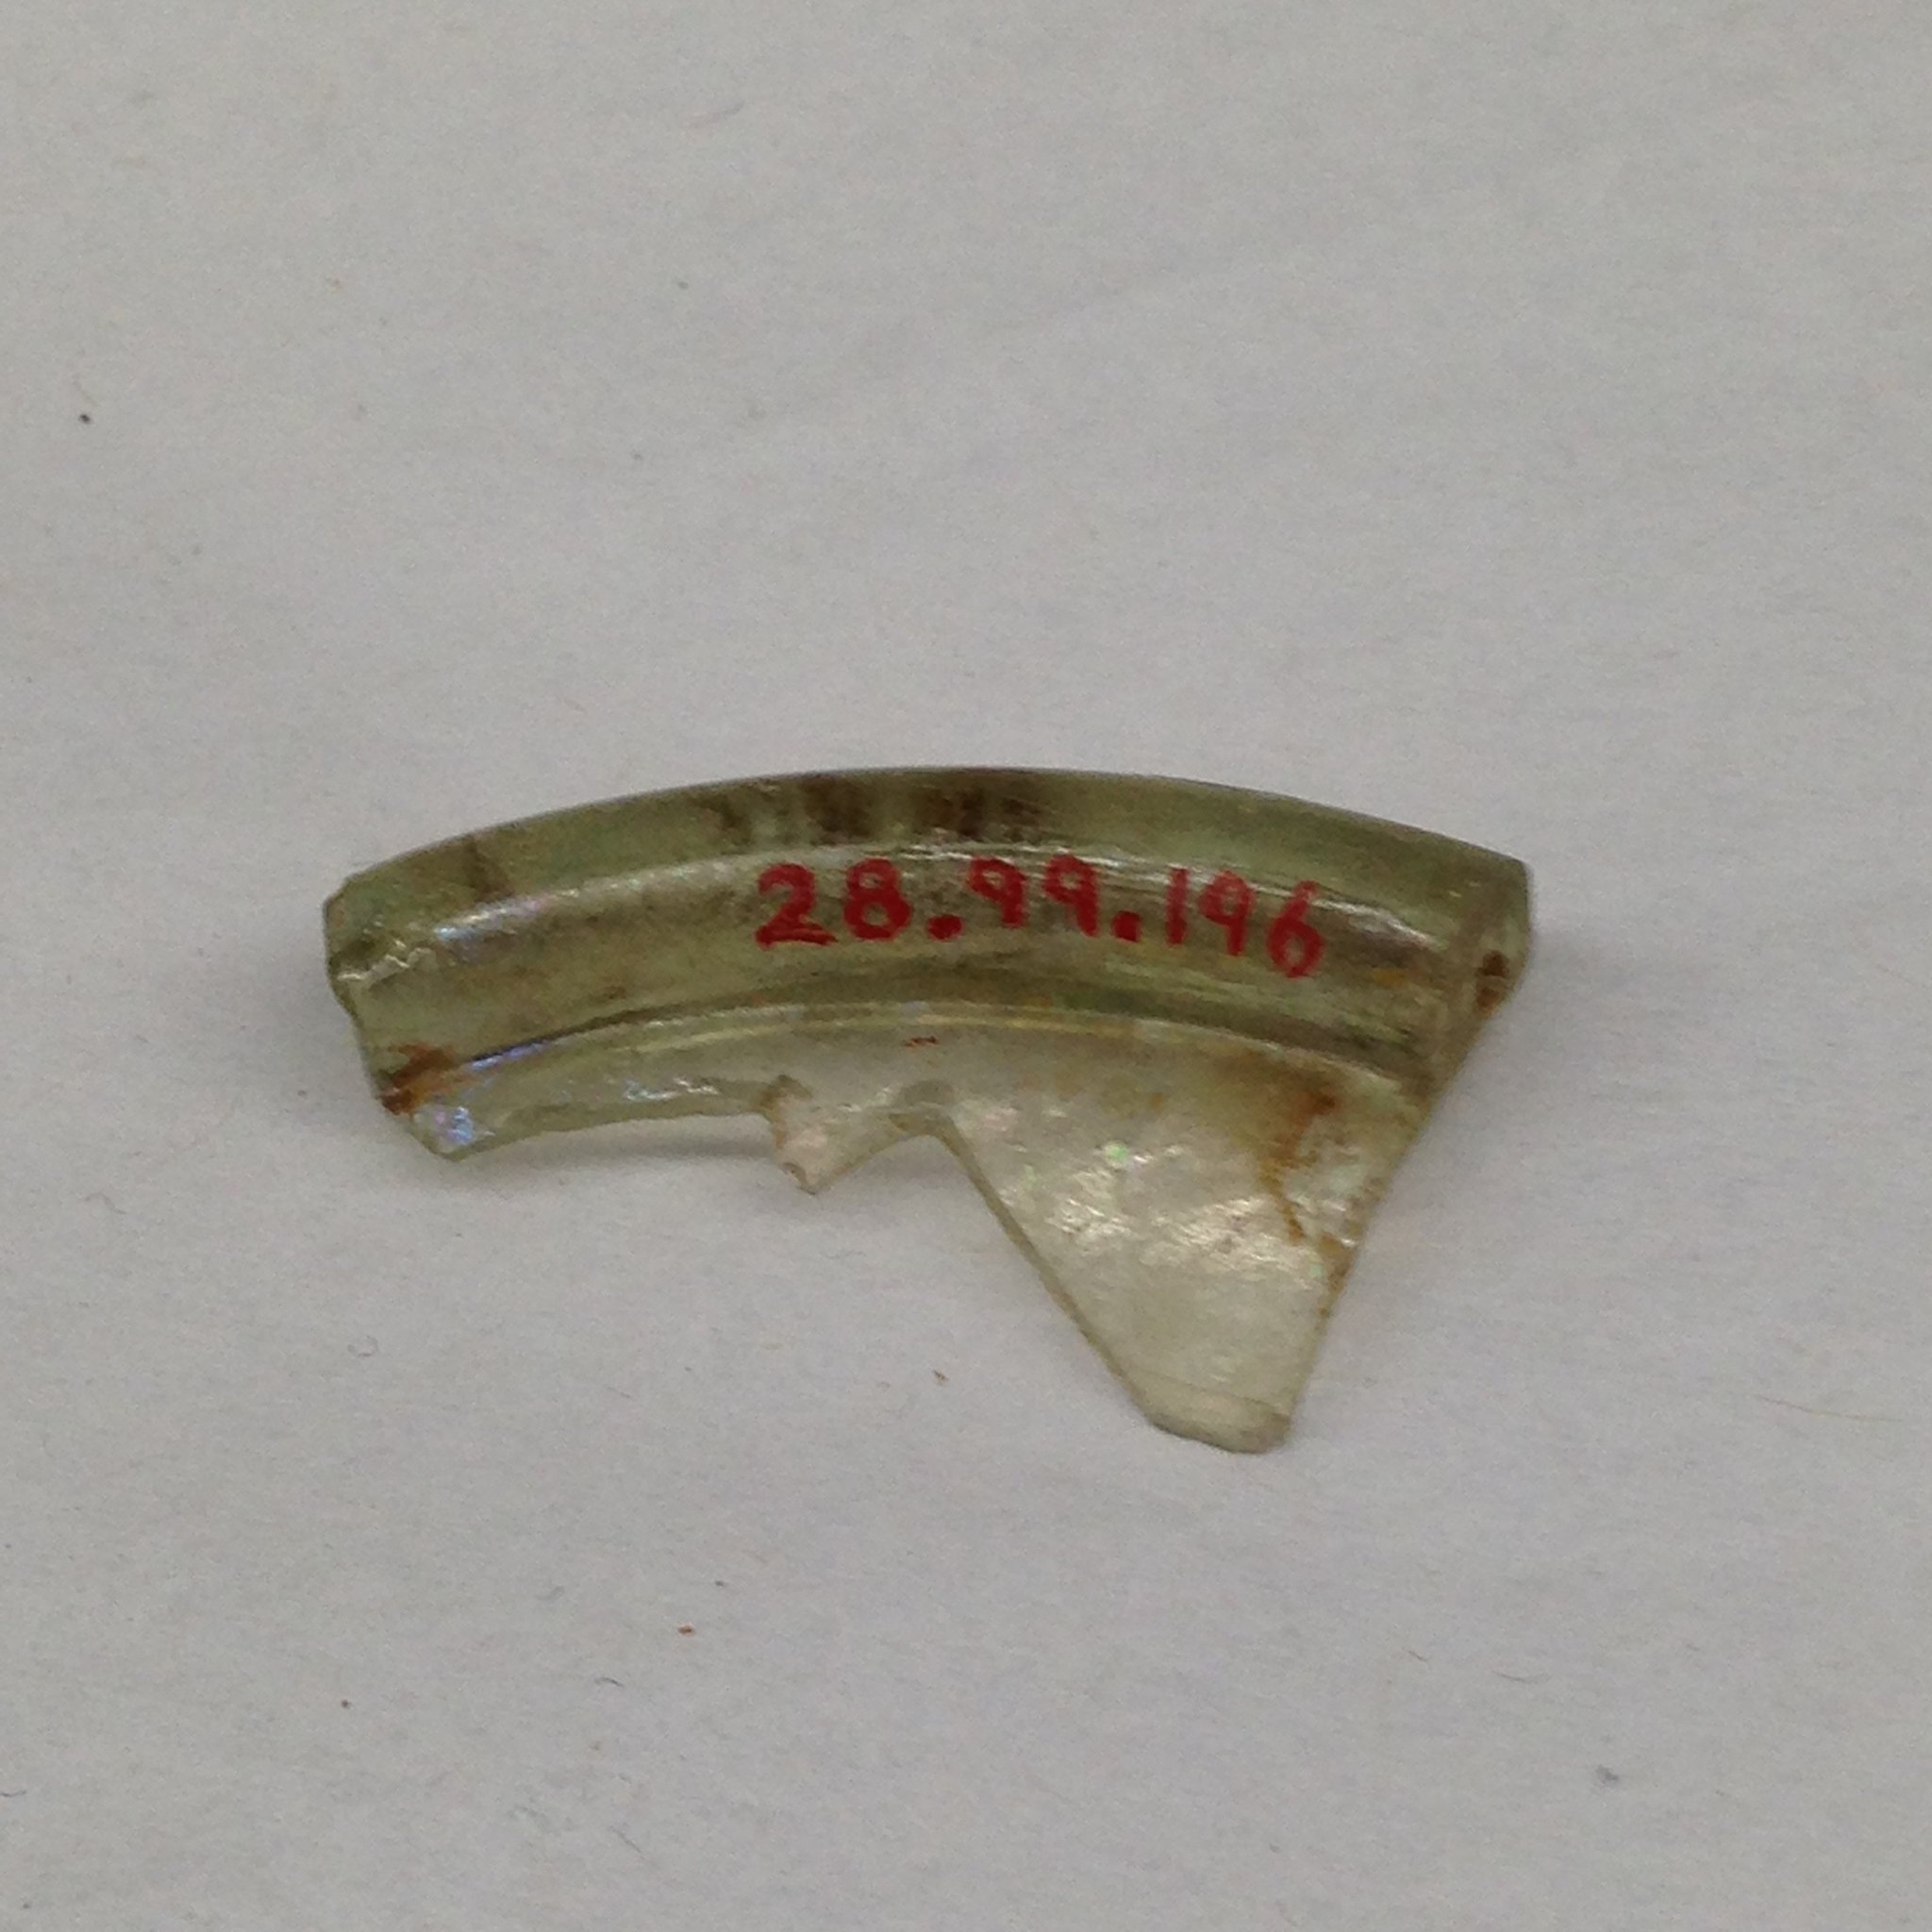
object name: fragment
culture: european or middle eastern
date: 1150-1250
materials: ceramic, glass